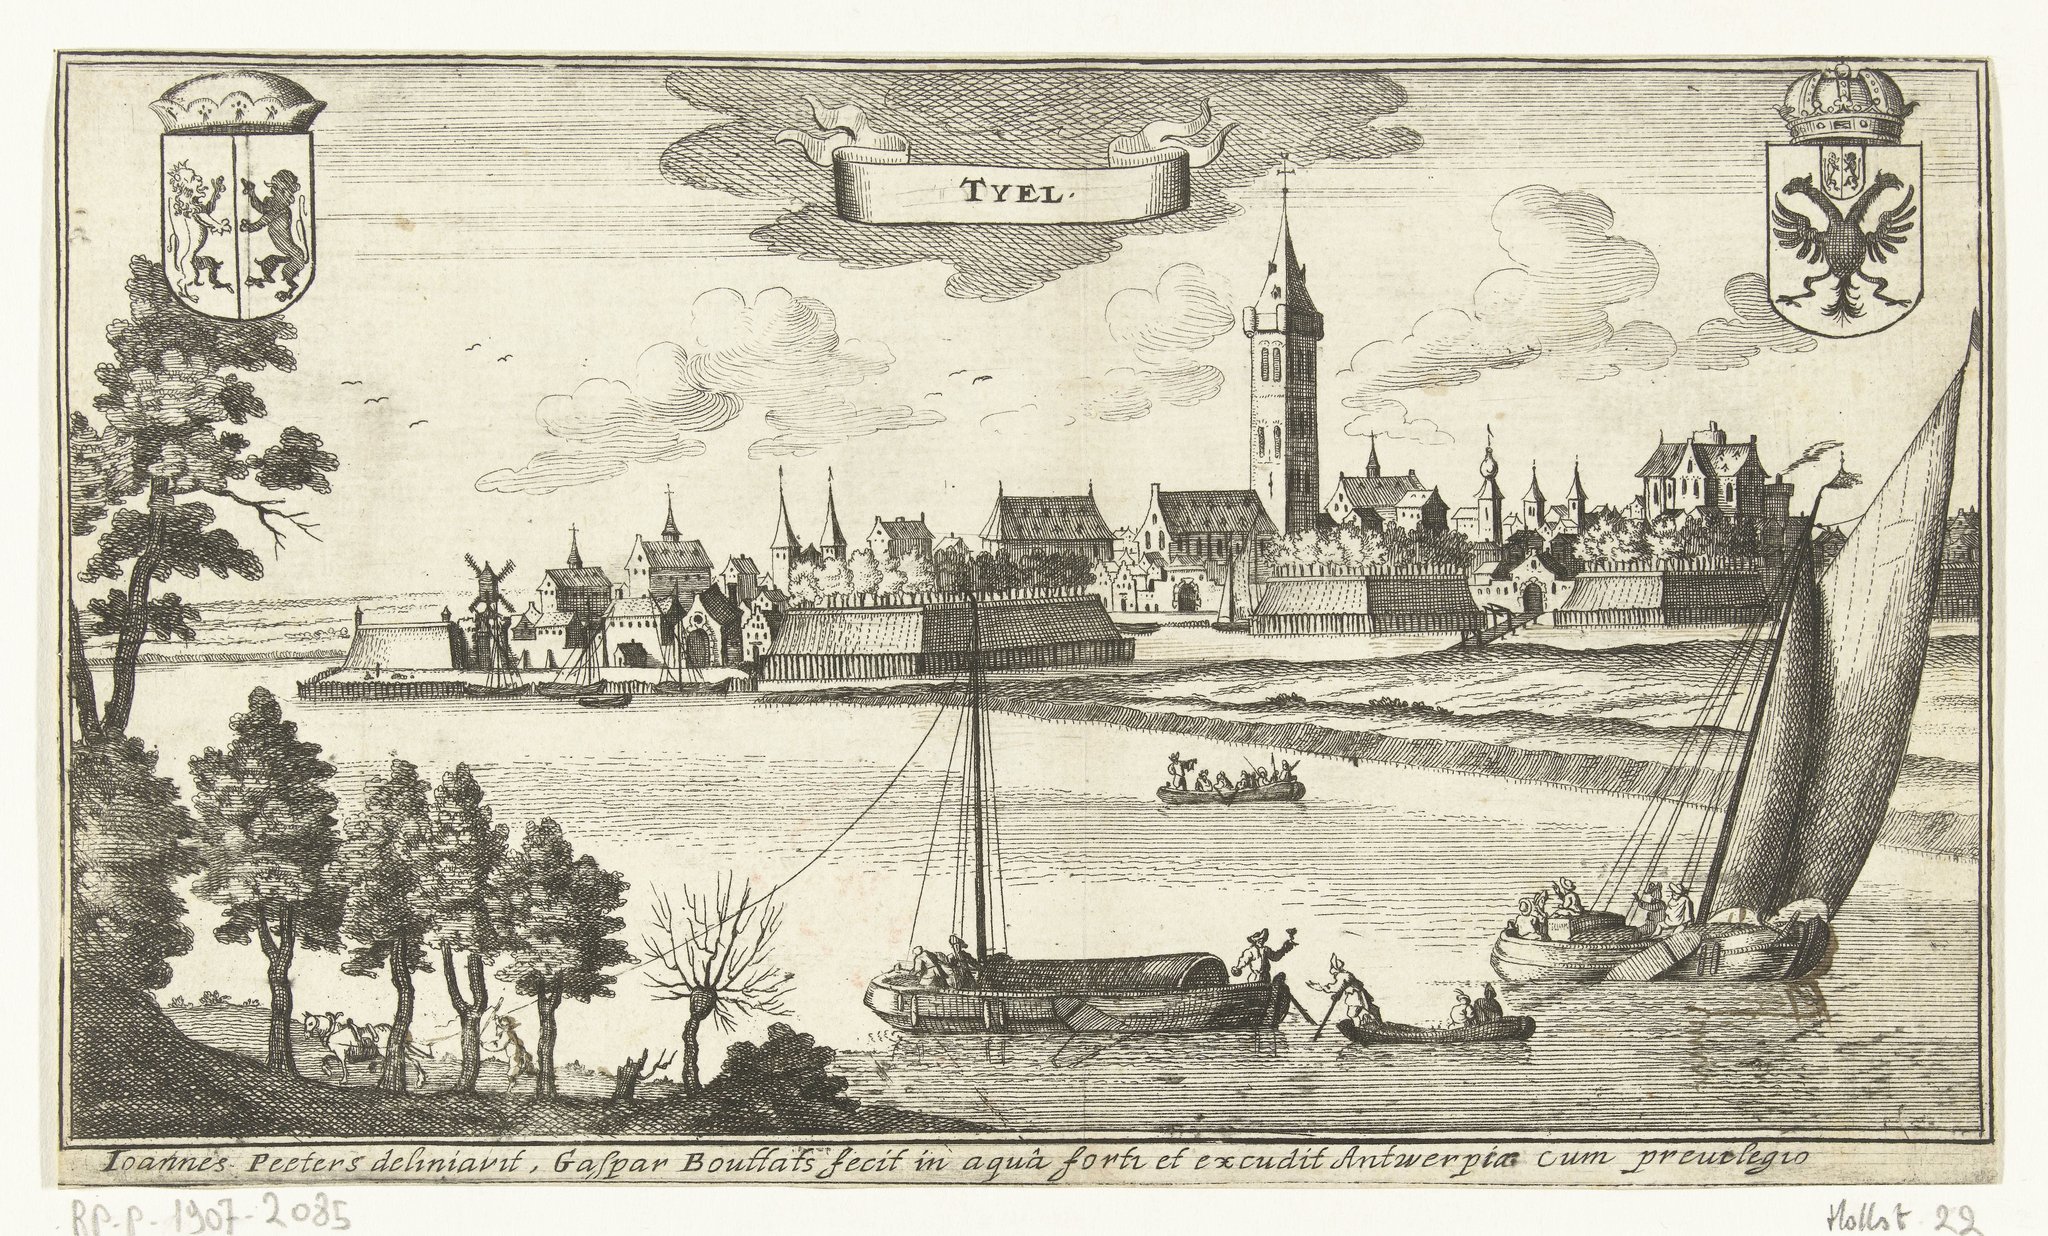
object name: print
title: Gezicht op Tiel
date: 1679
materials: paper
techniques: etching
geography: antwerp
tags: prospect of city, town panorama, silhouette of city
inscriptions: inscription: ‘Tijel ligt in gelderlant op de rechte zijnde van de waele 2 mijlen van Bommel etc...’, collector's mark: Lugt 2228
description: Gezicht op de stad Tiel. Op de voorgrond, buiten de stadsmuren, de rivier De Waal. Een sloep wordt door paarden voortgetrokken. Er varen ook andere schepen. Boven het stadsgezicht een cartouche met de naam van de stad en het wapenschild.